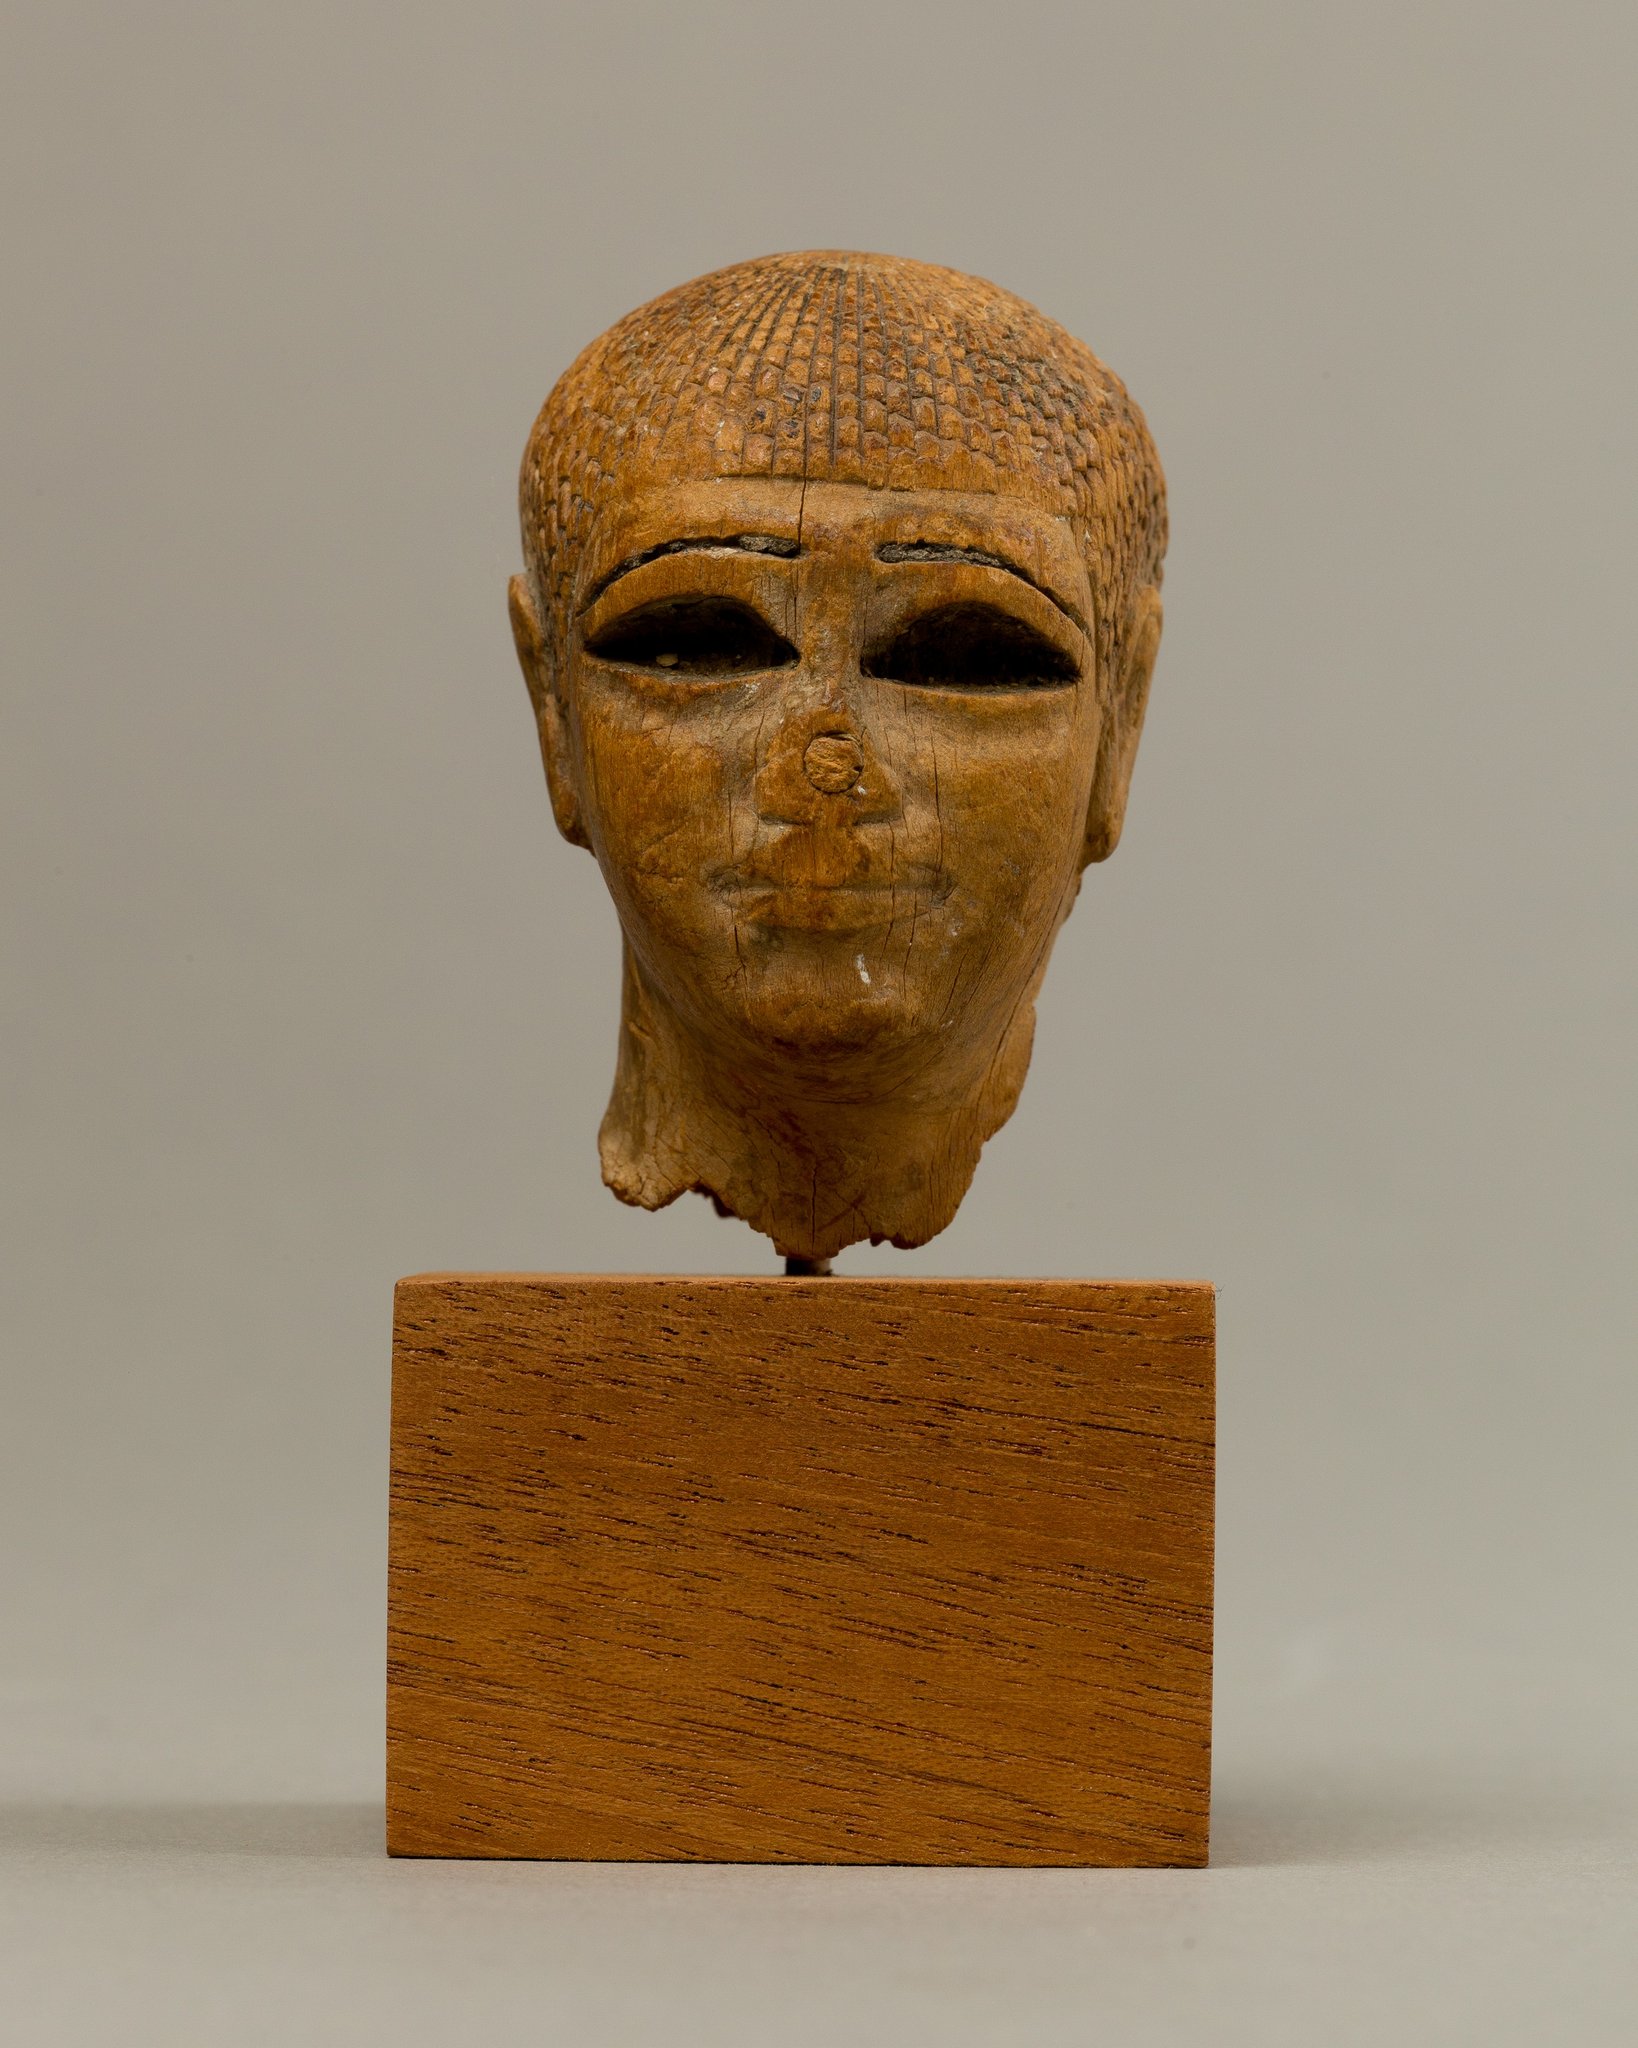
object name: head, female statuette, from tomb of khety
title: Head of a Female Figure from the Tomb of Khety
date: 2051-2000 BCE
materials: paint, paste, wood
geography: egypt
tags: heads,women